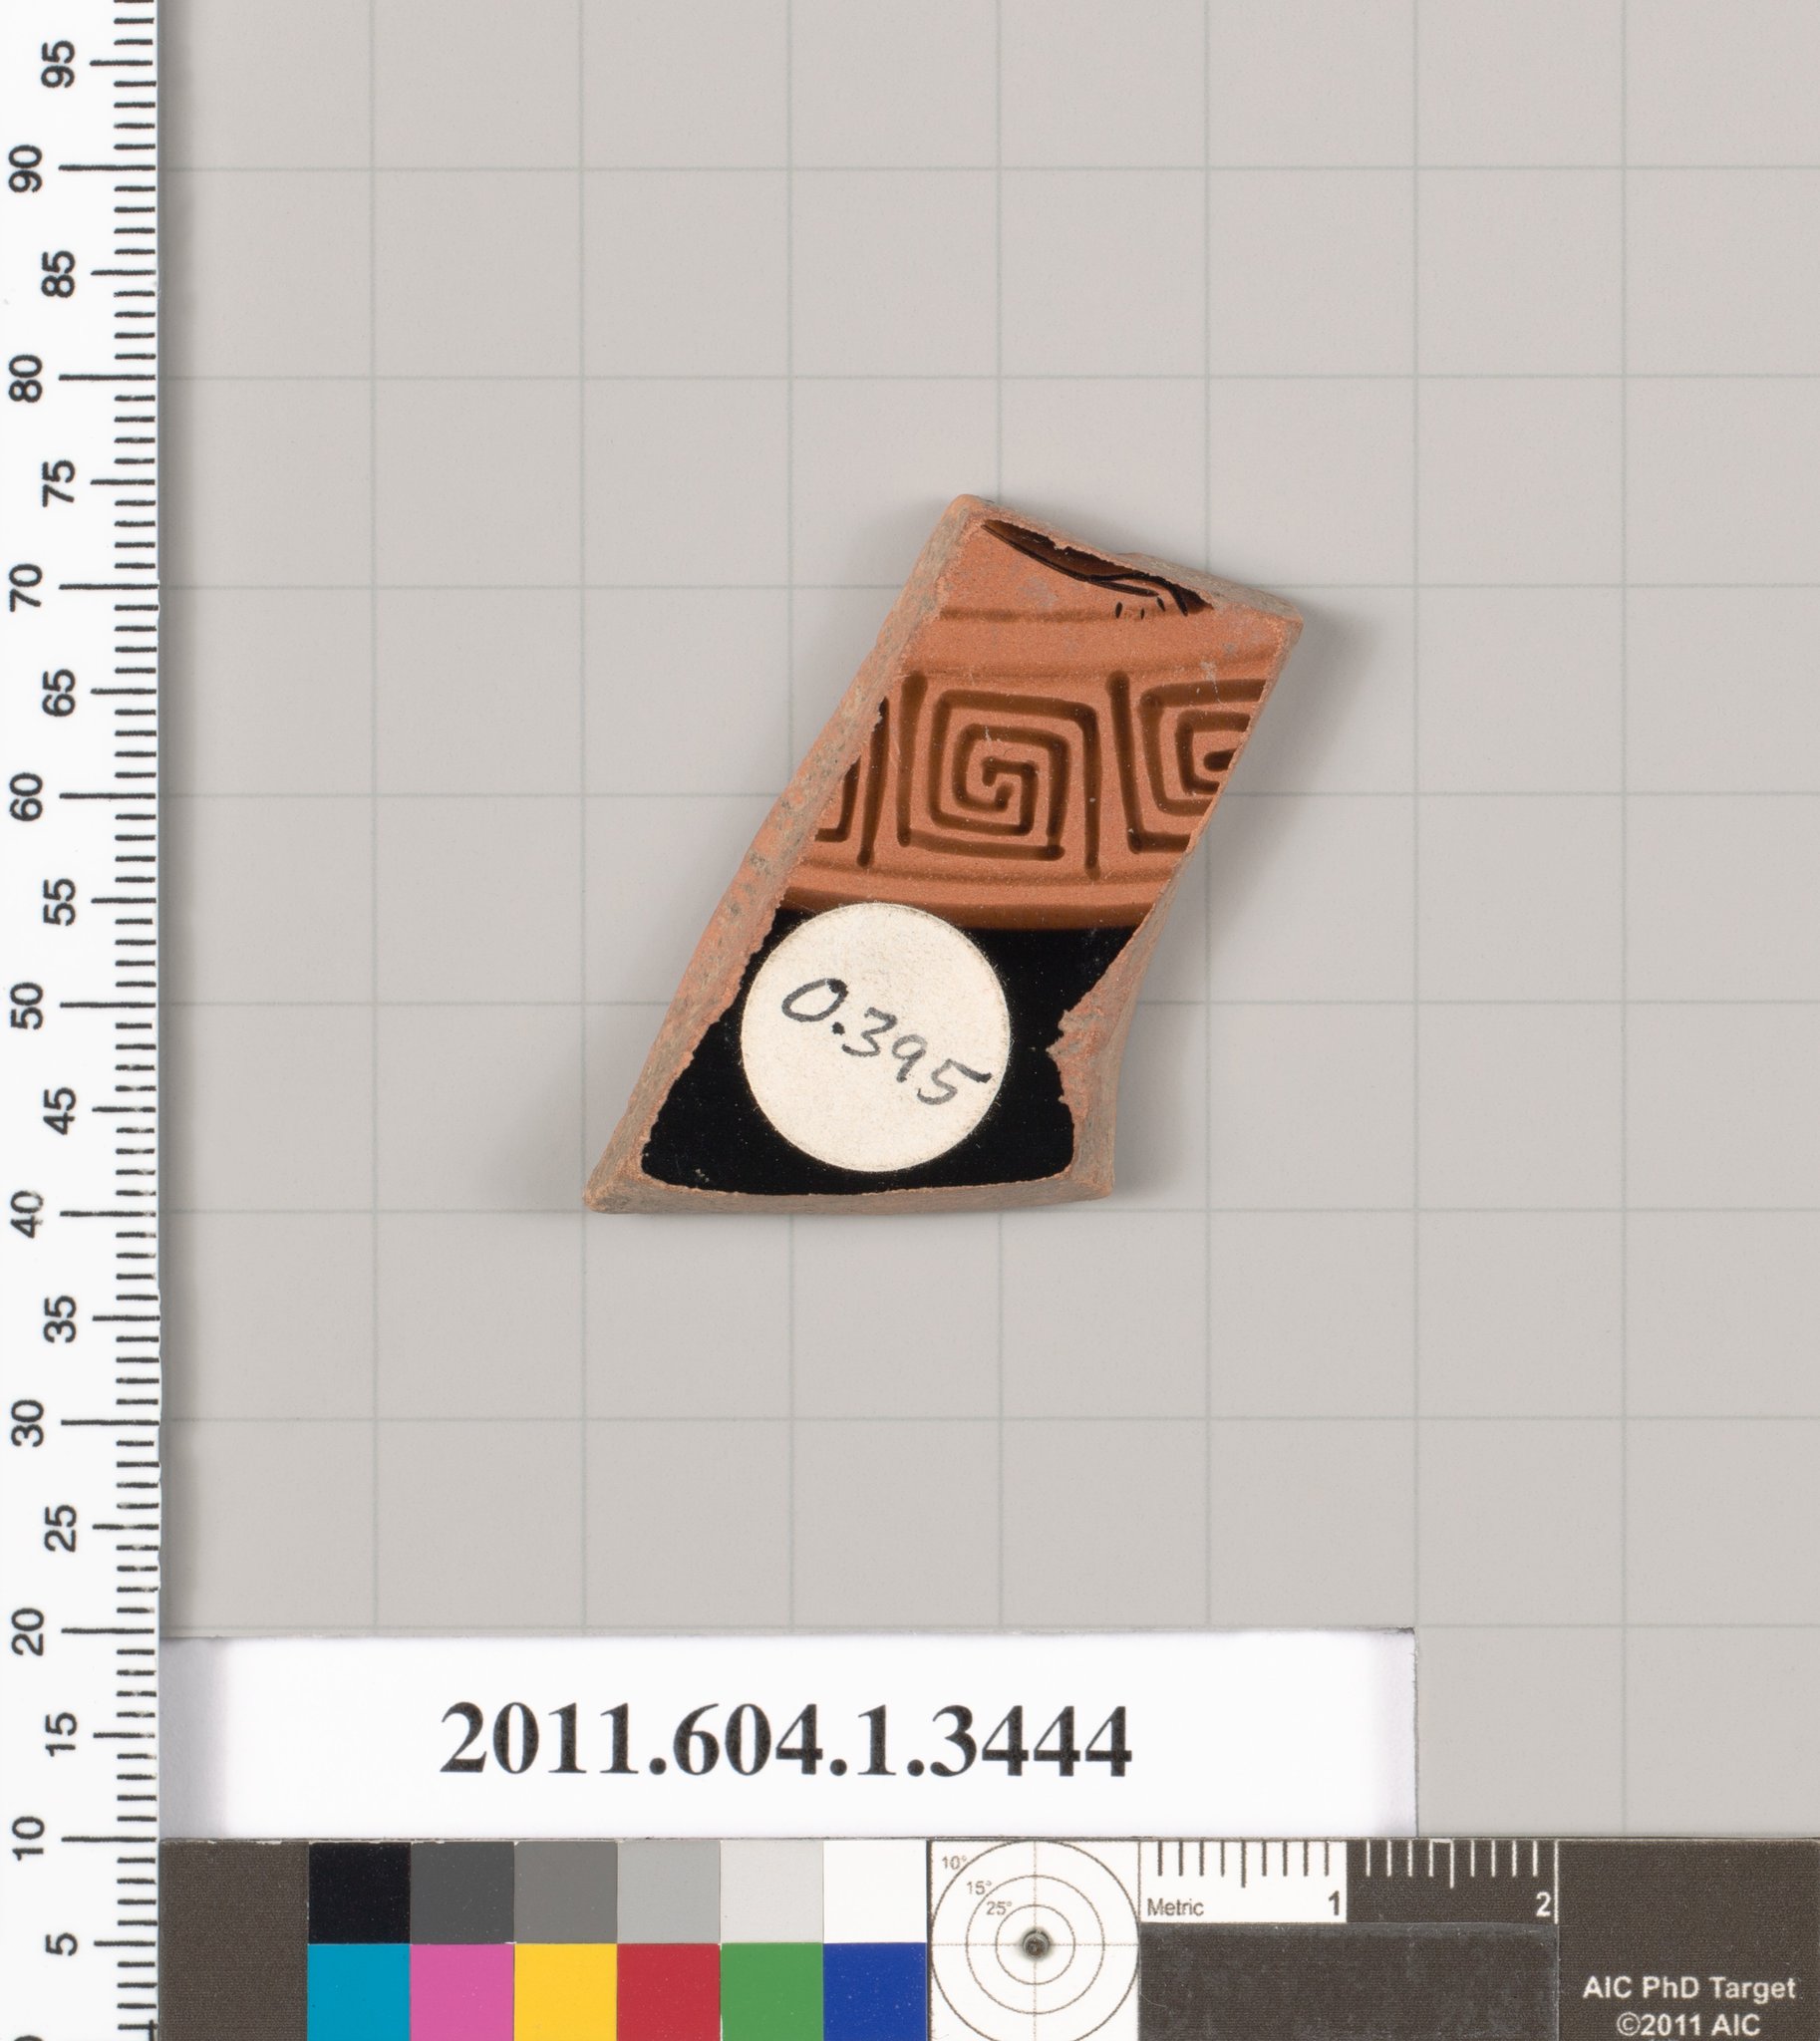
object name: kylix fragment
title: Terracotta fragment of a kylix (drinking cup)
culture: greek, attic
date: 475-451 BCE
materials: terracotta